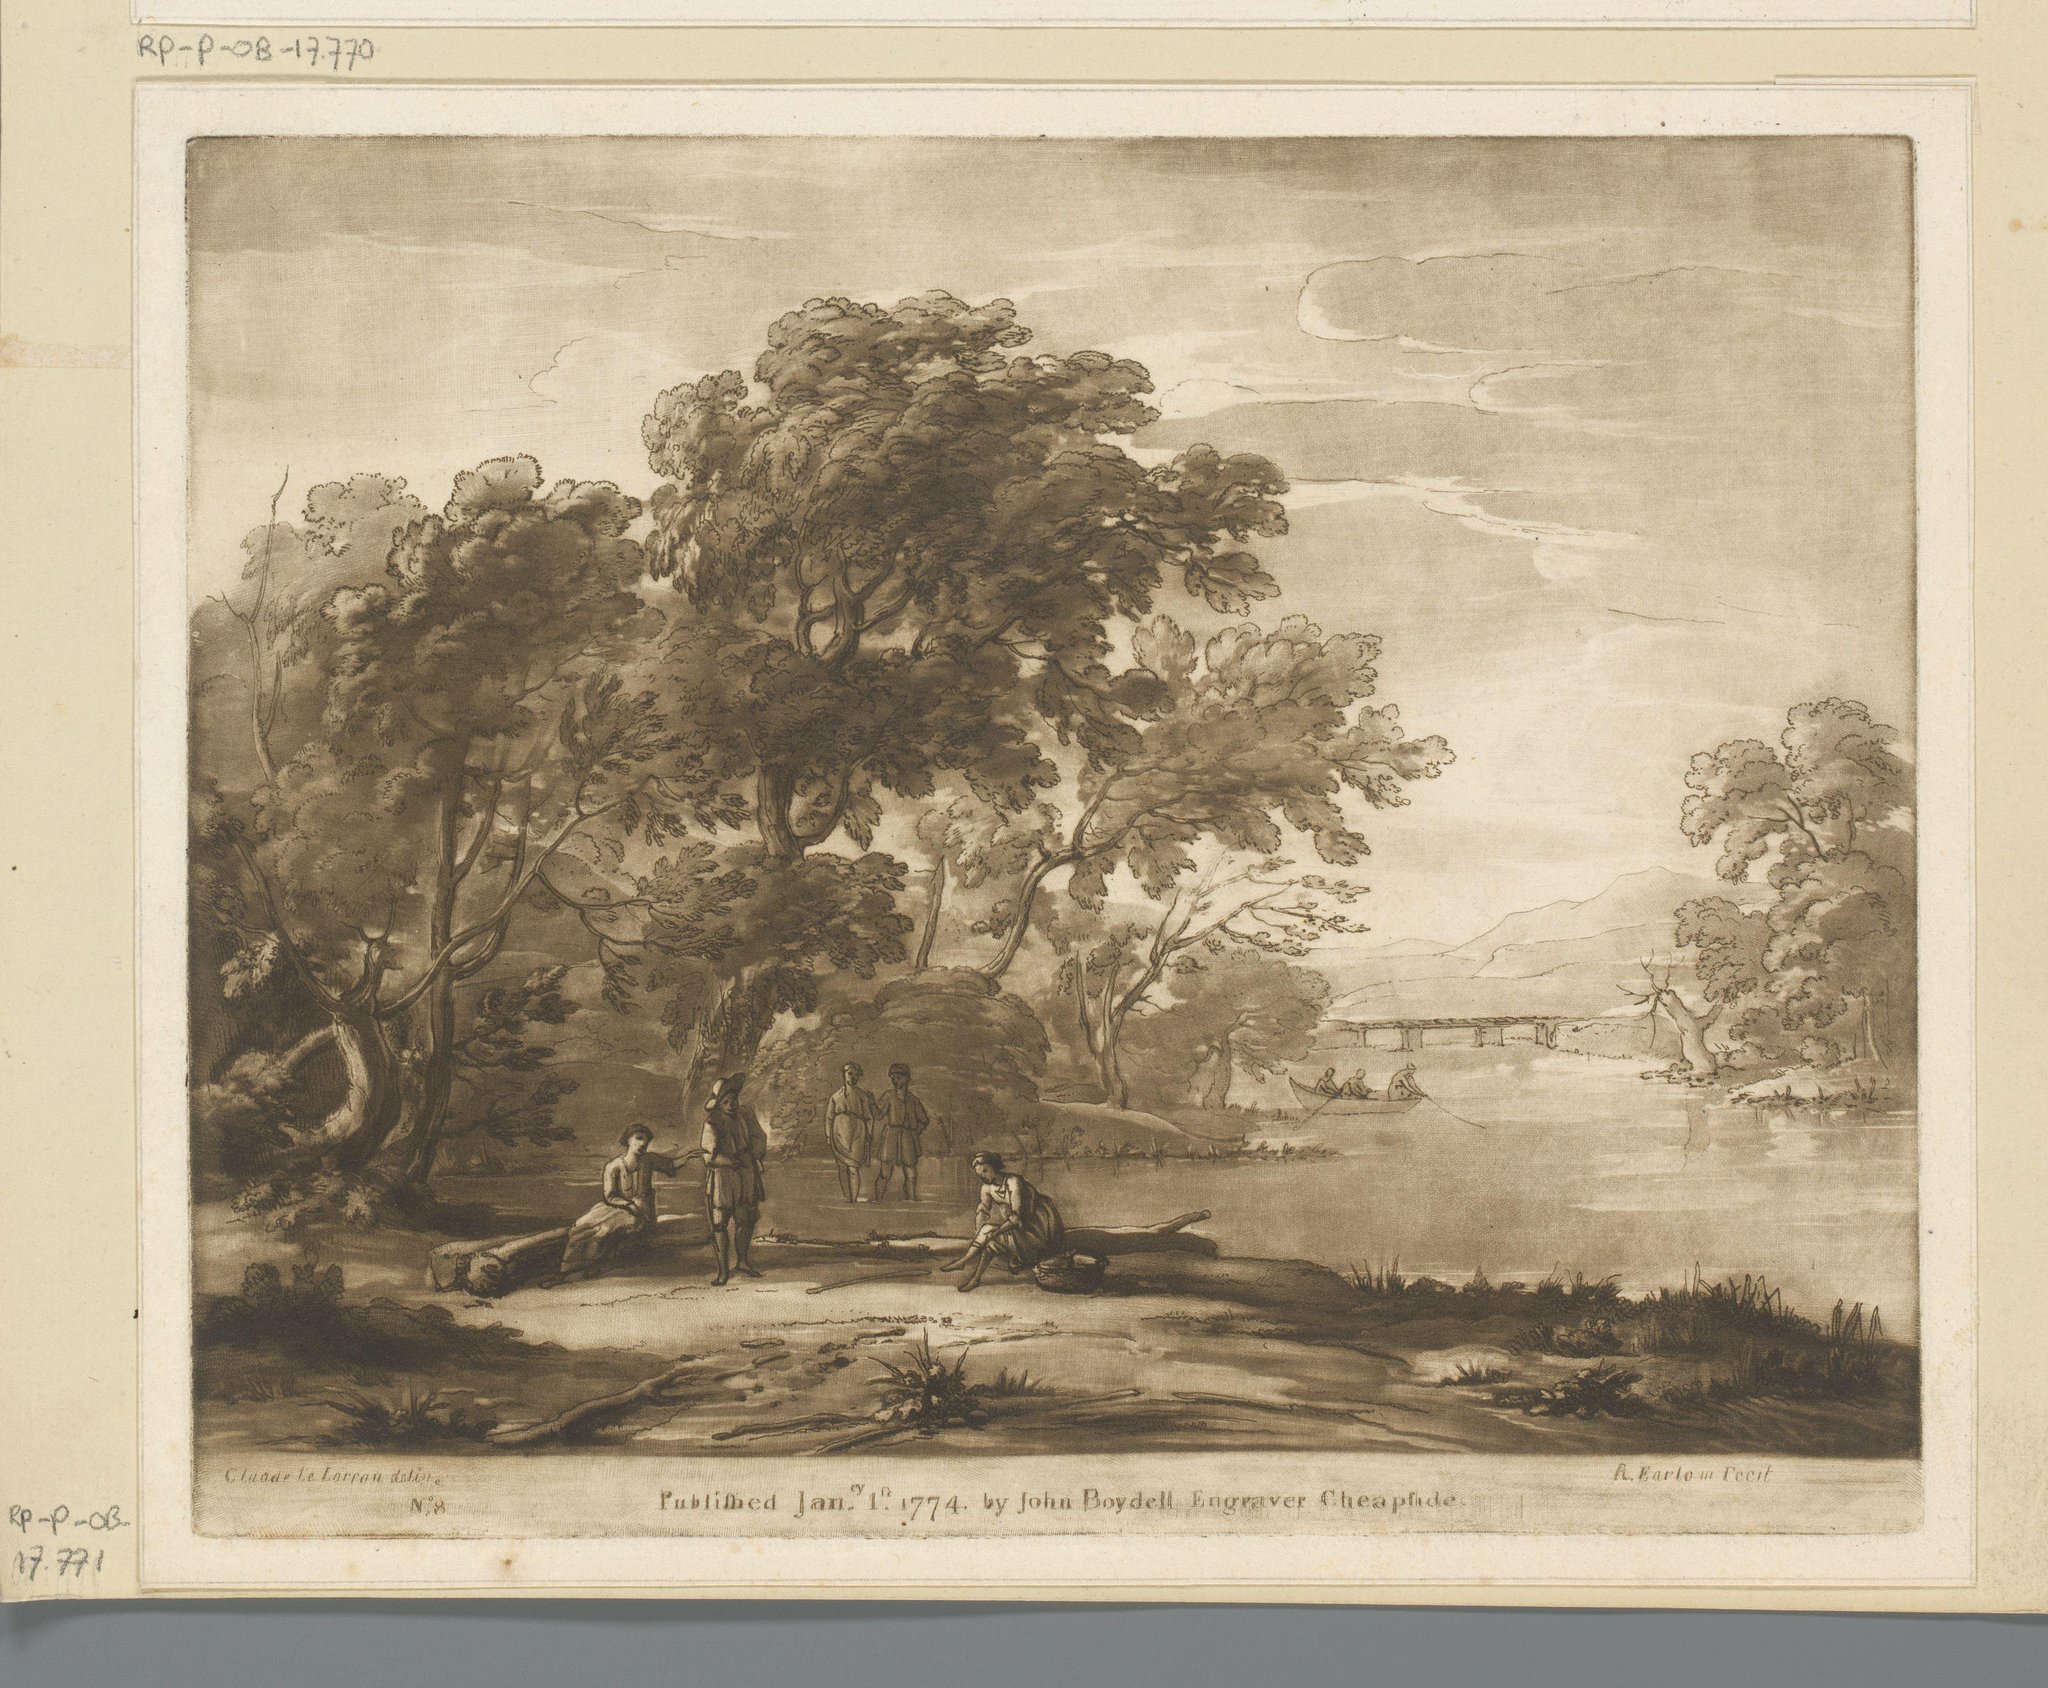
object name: print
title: Prenten naar tekeningen van Claude Lorrain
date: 1774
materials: paper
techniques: etching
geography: london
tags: crossing a river, river, landscape with bridge, viaduct or aqueduct, forest, wood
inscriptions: date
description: Vanaf 1774 publiceerde John Boydell tweehonderd prenten naar het tekeningenboek Liber Veritatis van Claude Lorrain, in het bezit van de hertogen van Cavendish. Deze werden vanaf 1777 in twee volumes gebundeld uitgegeven.